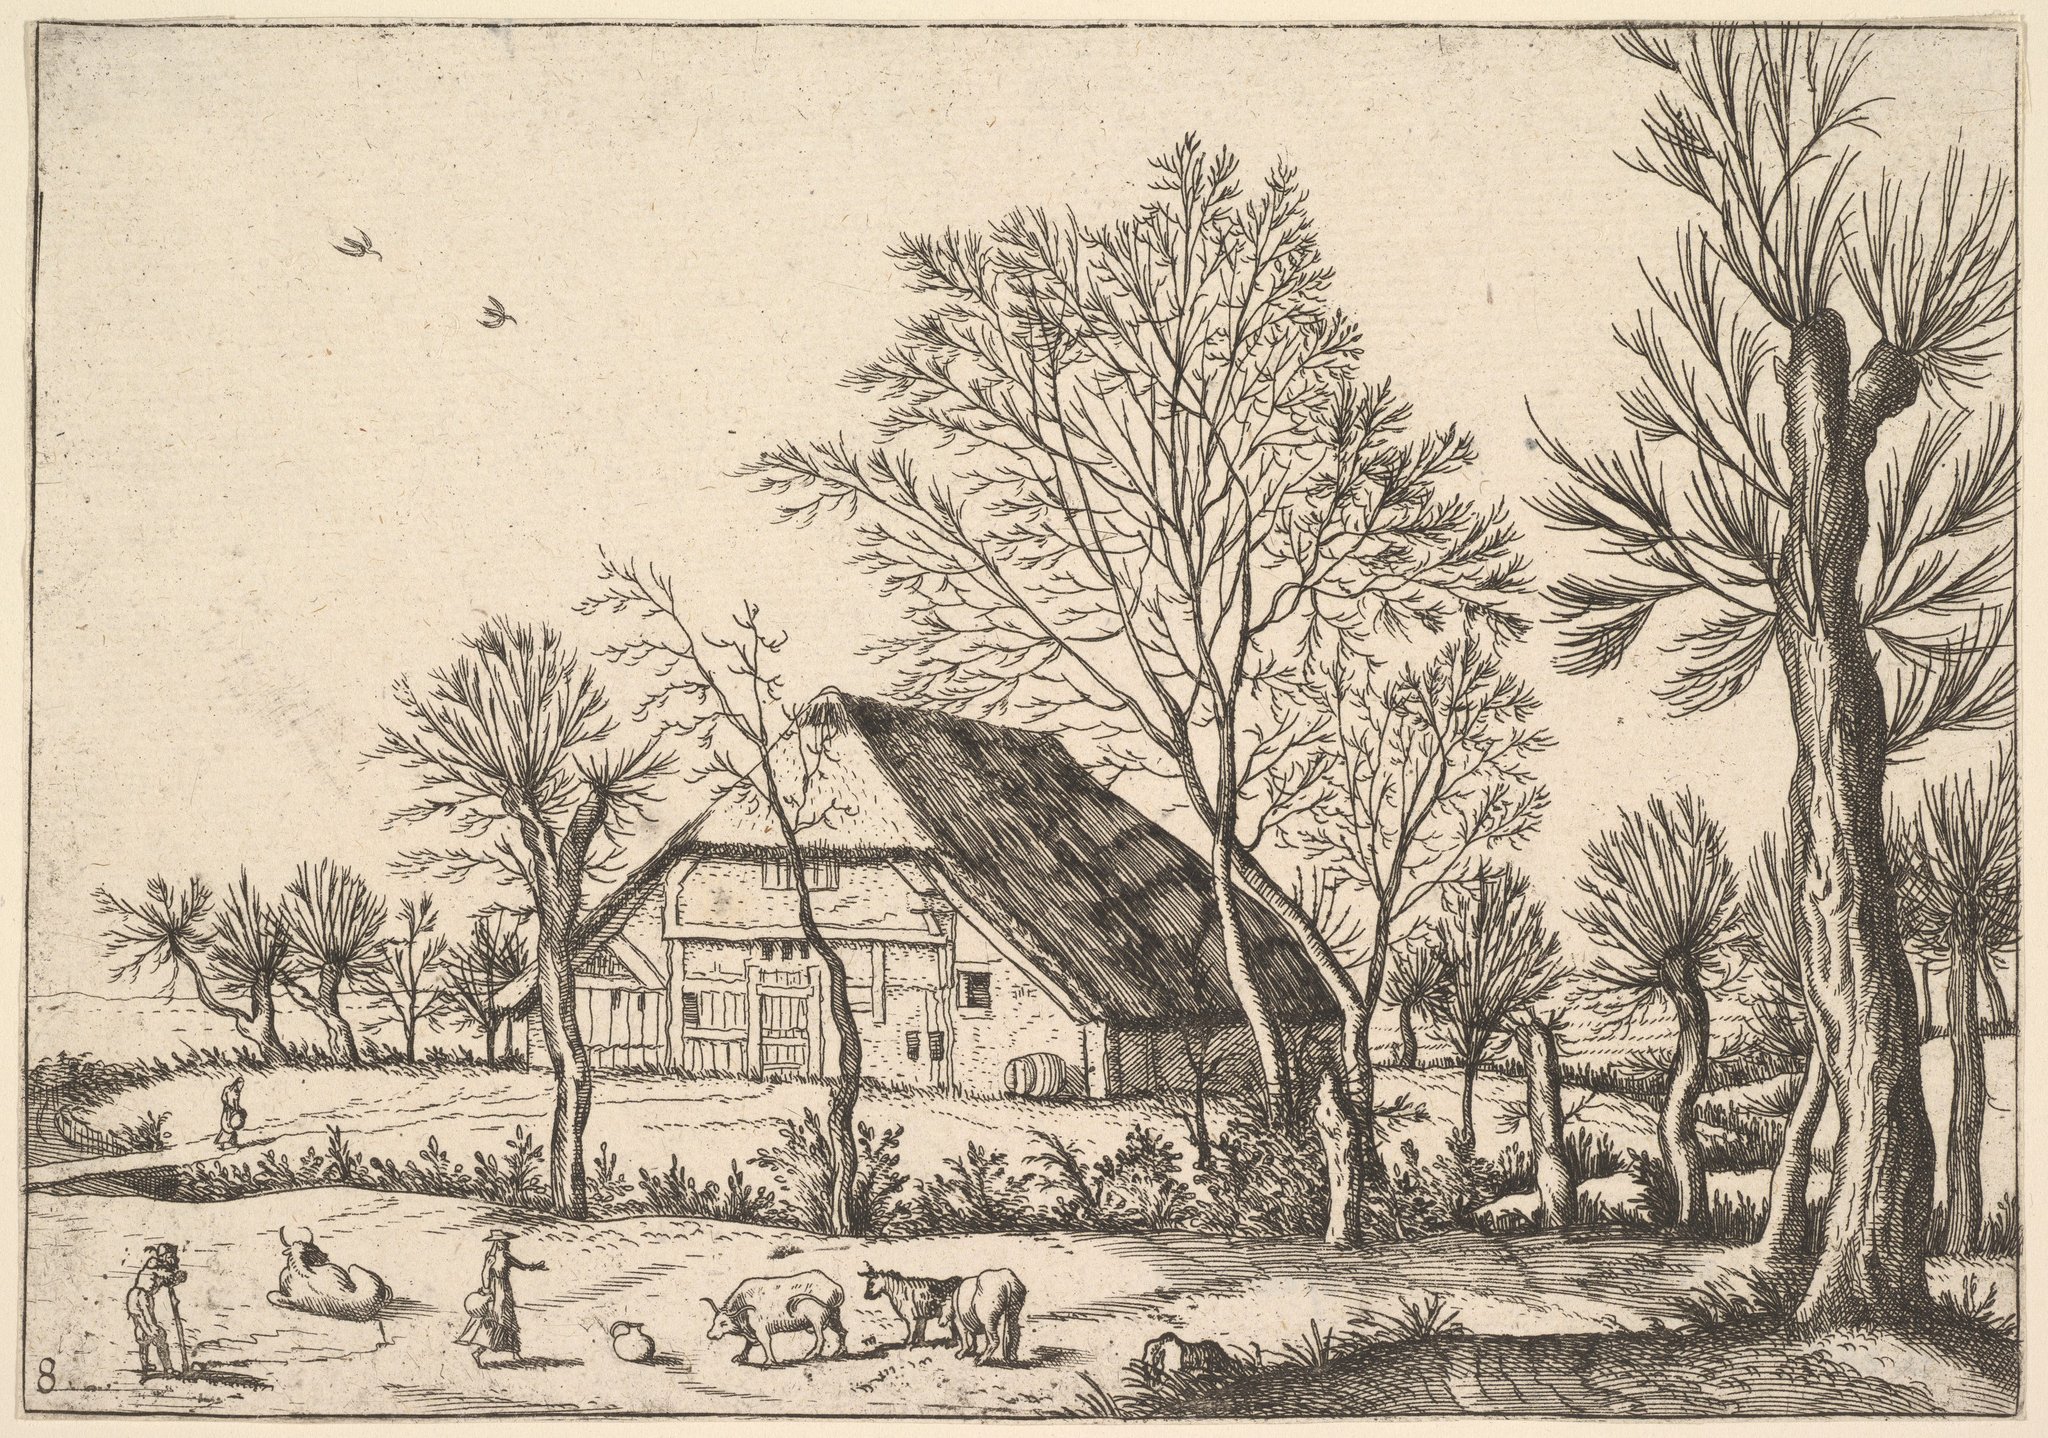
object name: print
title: Farm, from The Small Landscapes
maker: johannes van doetecum i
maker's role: artist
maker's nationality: netherlandish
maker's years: 1528-1605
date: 1559-1561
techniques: etching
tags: farms,landscapes